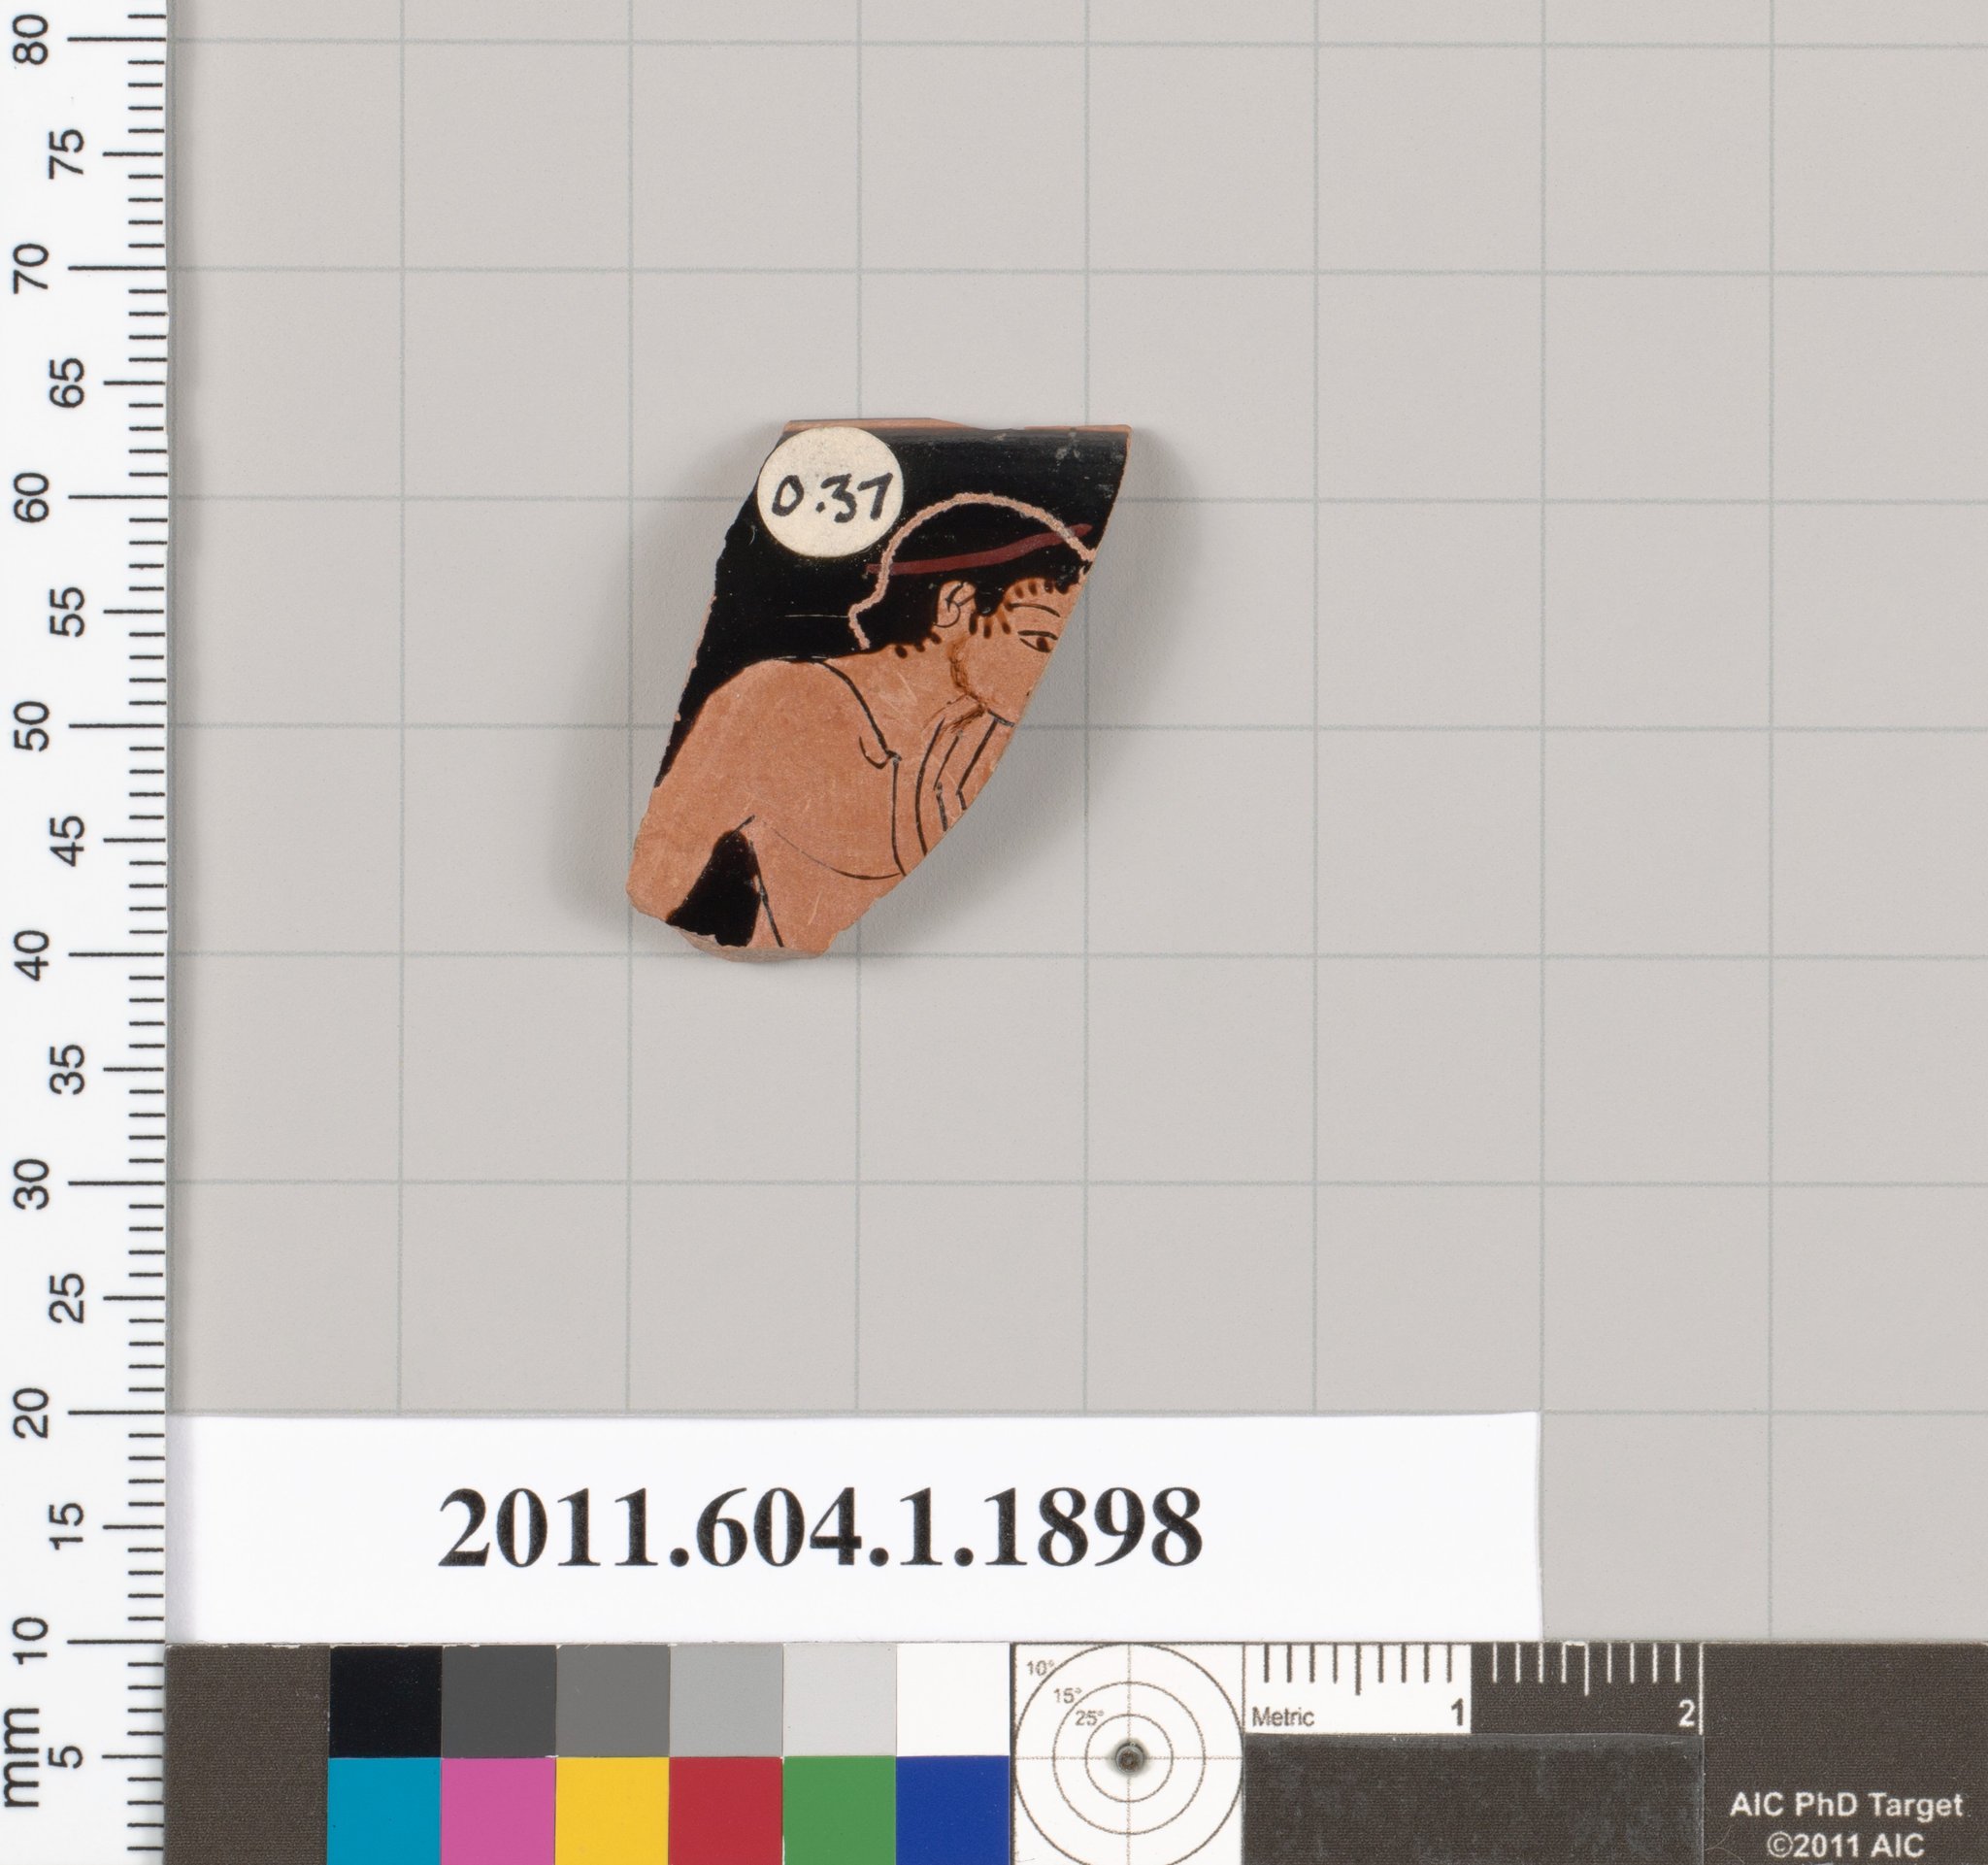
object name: kylix fragment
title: Terracotta rim fragment of a kylix (drinking cup)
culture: greek, attic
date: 534-501 BCE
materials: terracotta